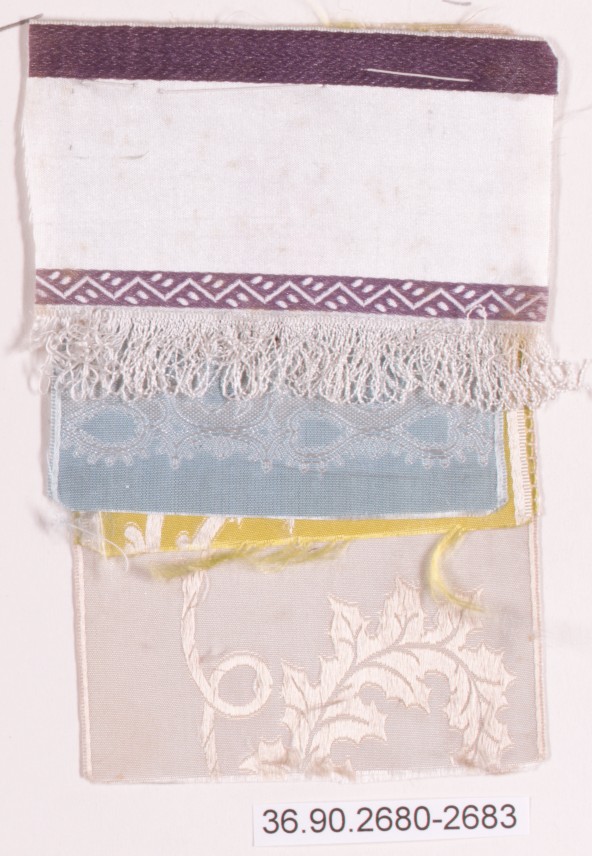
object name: ribbon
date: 1801-1900